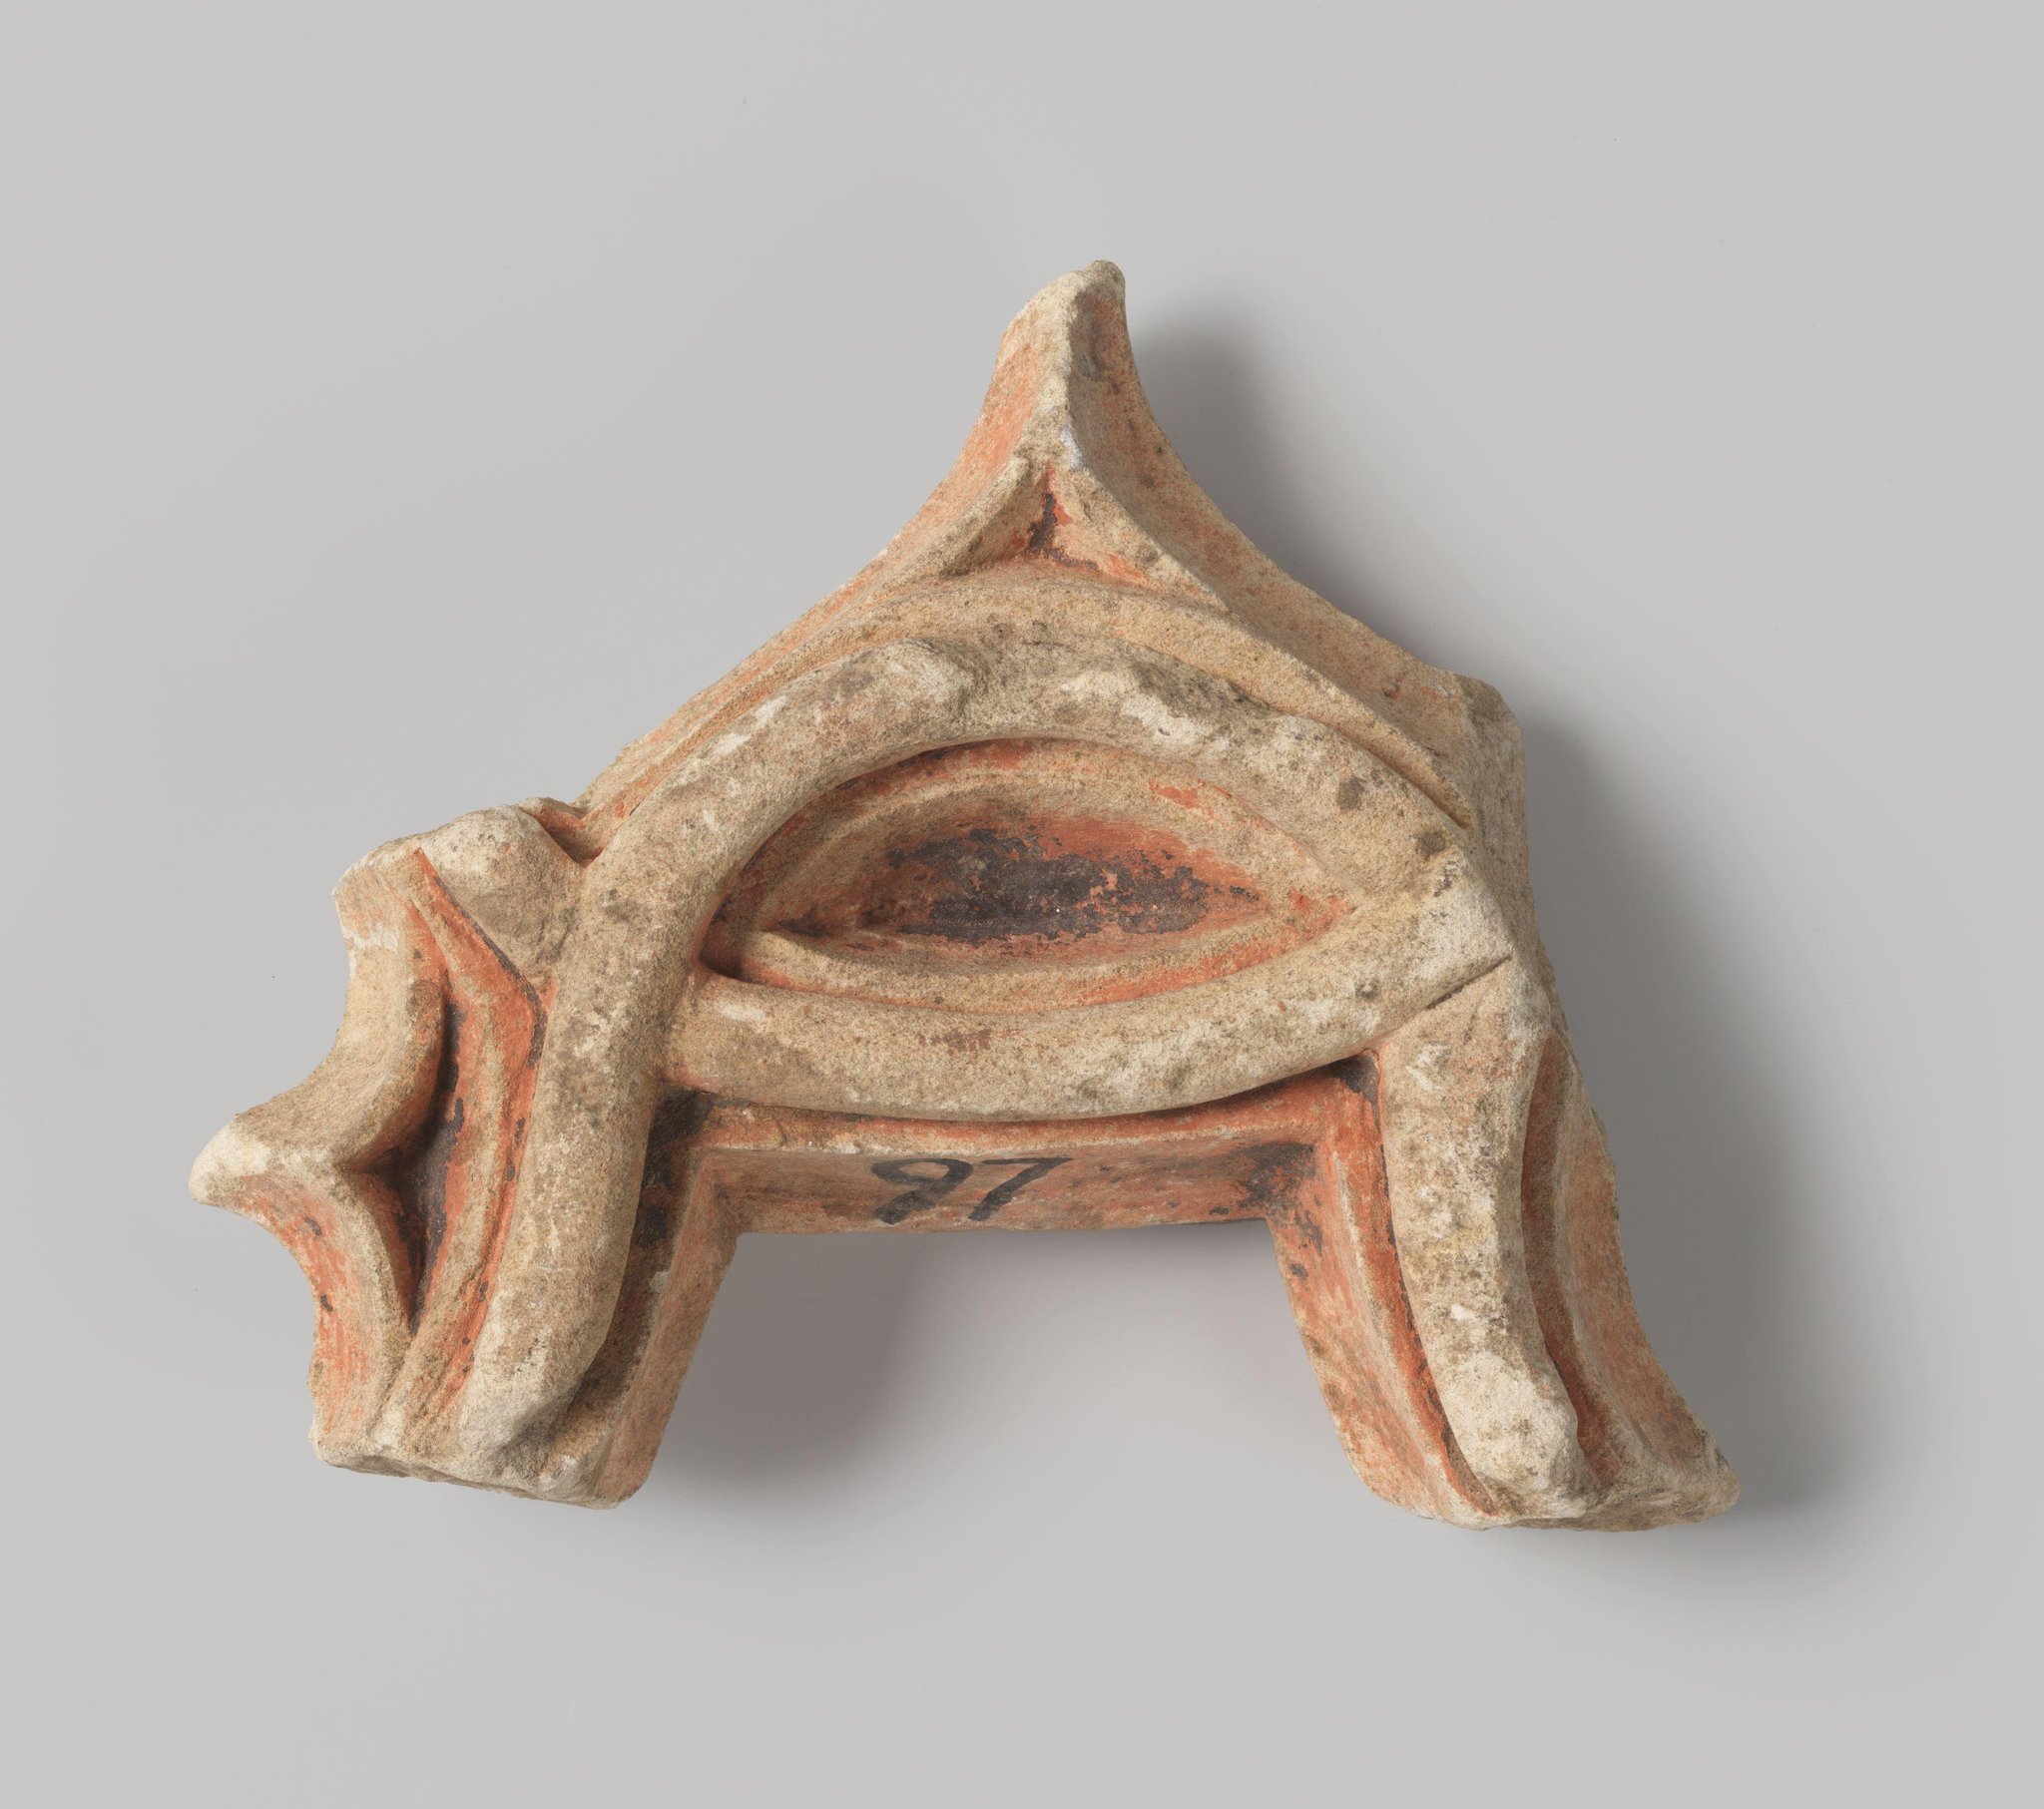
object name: tracery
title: Maaswerk, opgegraven te Utrecht bij het oude Minderbroederklooster (fragmenten)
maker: Anonymous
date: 1400-1950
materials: stone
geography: utrecht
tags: minderbroedersklooster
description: Drie fragmenten van maaswerk. Opgegraven te Utrecht bij het oude Minderbroederklooster.